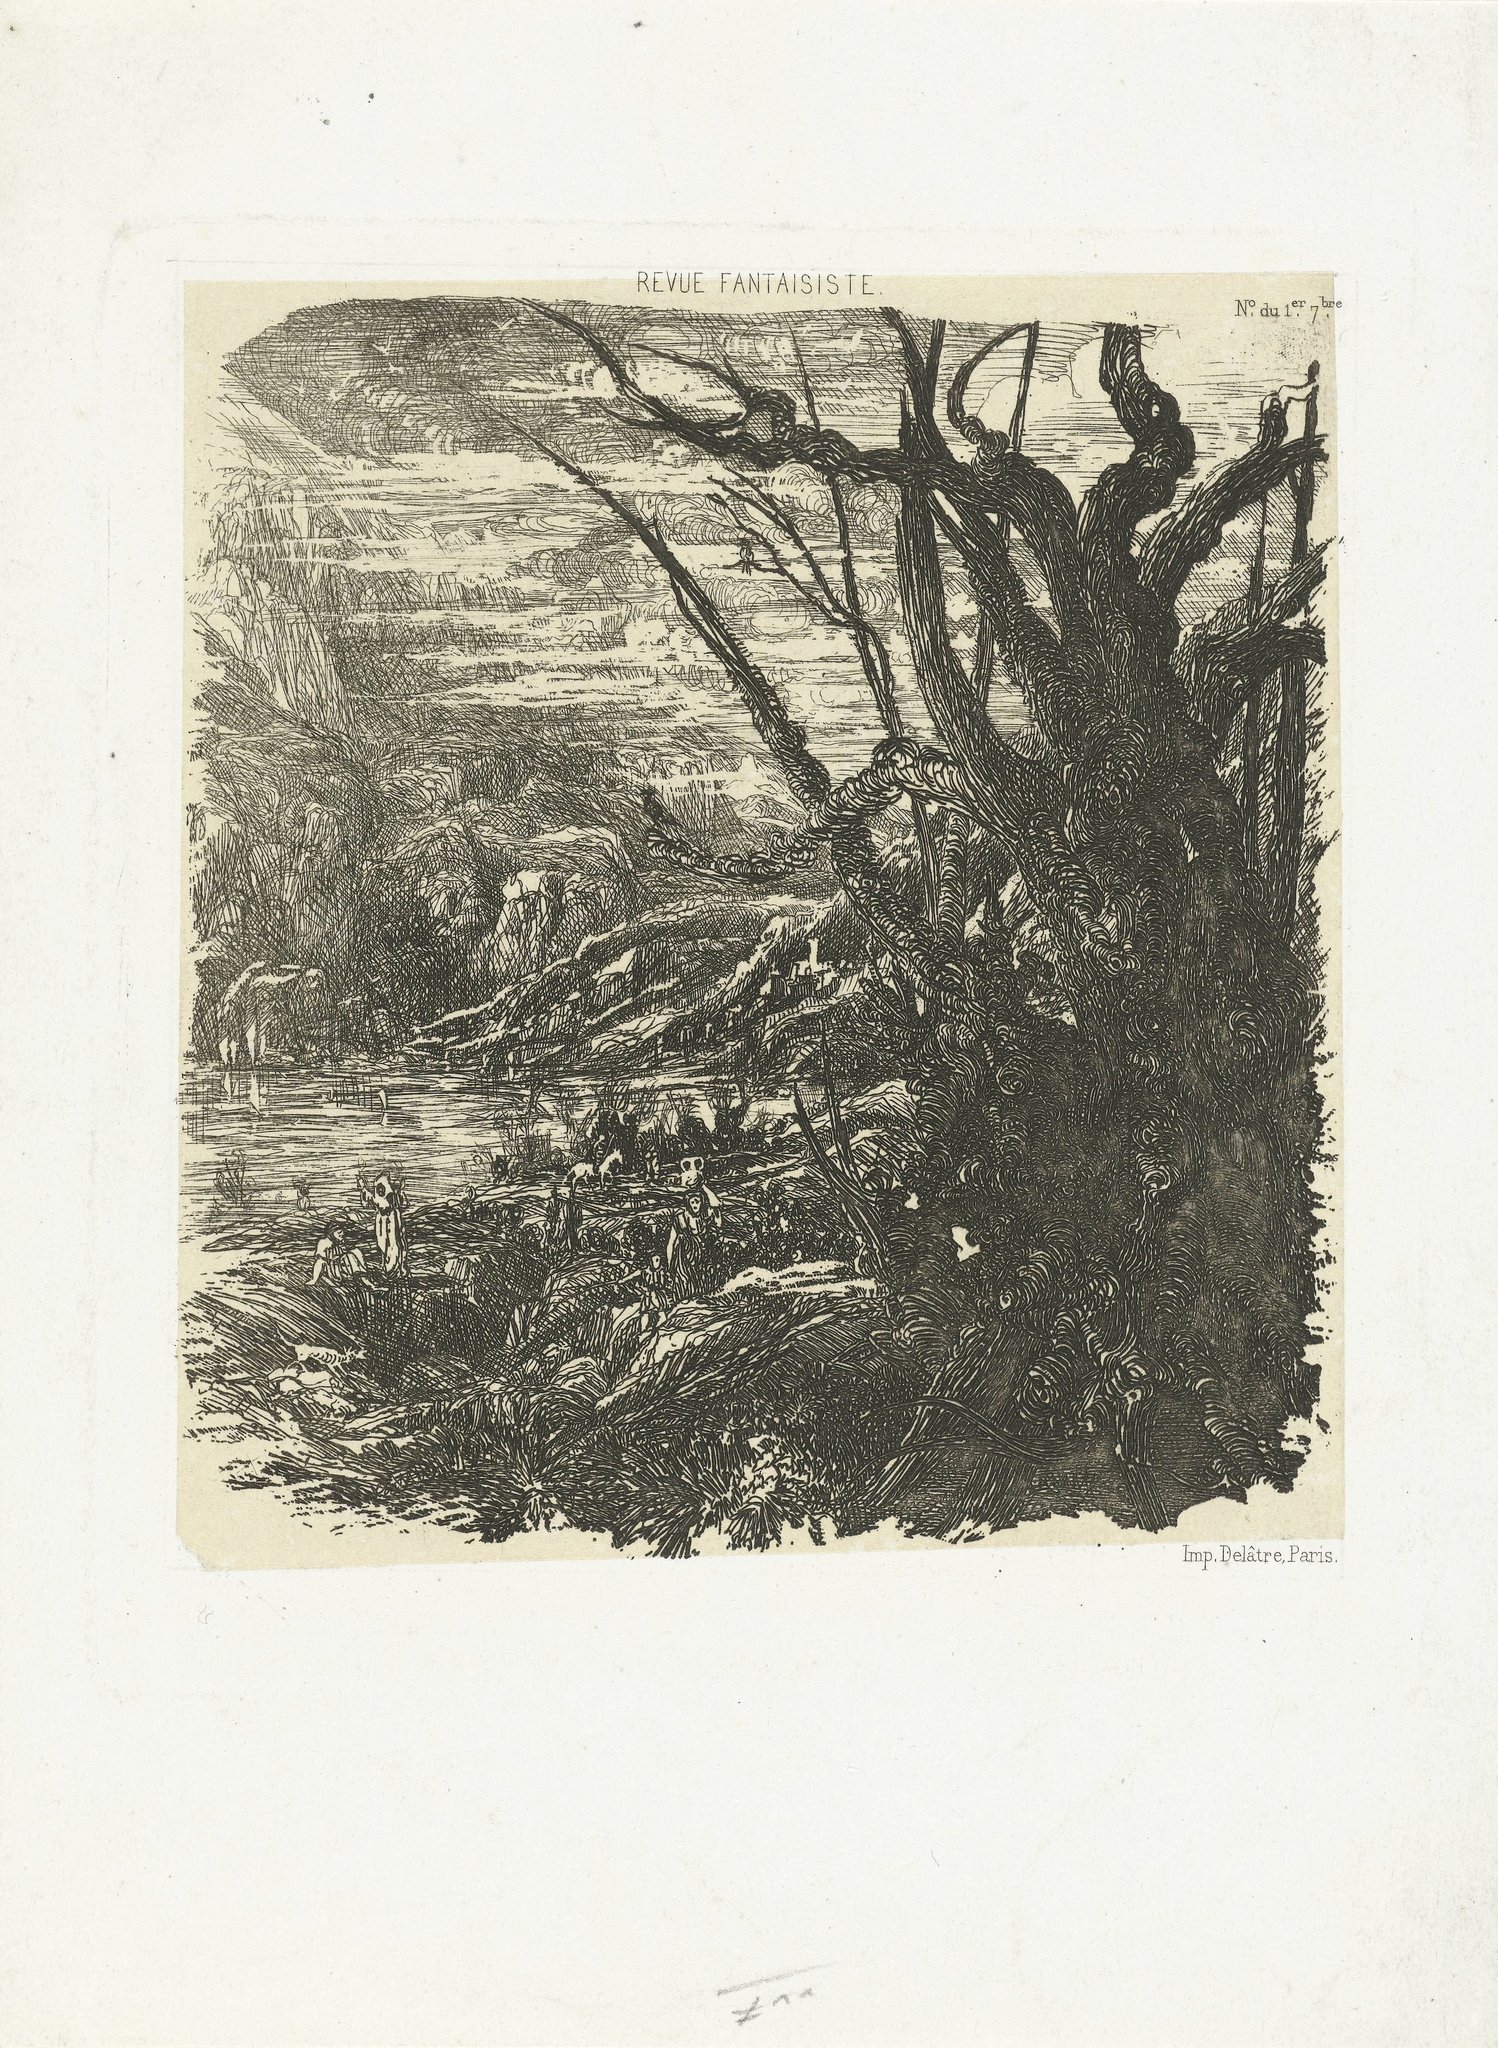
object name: print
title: Le lac dans les montagnes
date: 1861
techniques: printmaking, etching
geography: paris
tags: lake, groups of trees, mountains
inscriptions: collector's mark: Lugt 2228, collector's mark: Lugt 2760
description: Berglandschap met een meer. Op de voorgrond rechts staan knoestige kale bomen en op een pad langs het meer lopen reizigers. Boven de voorstelling staat de tekst Revue Fantaisiste